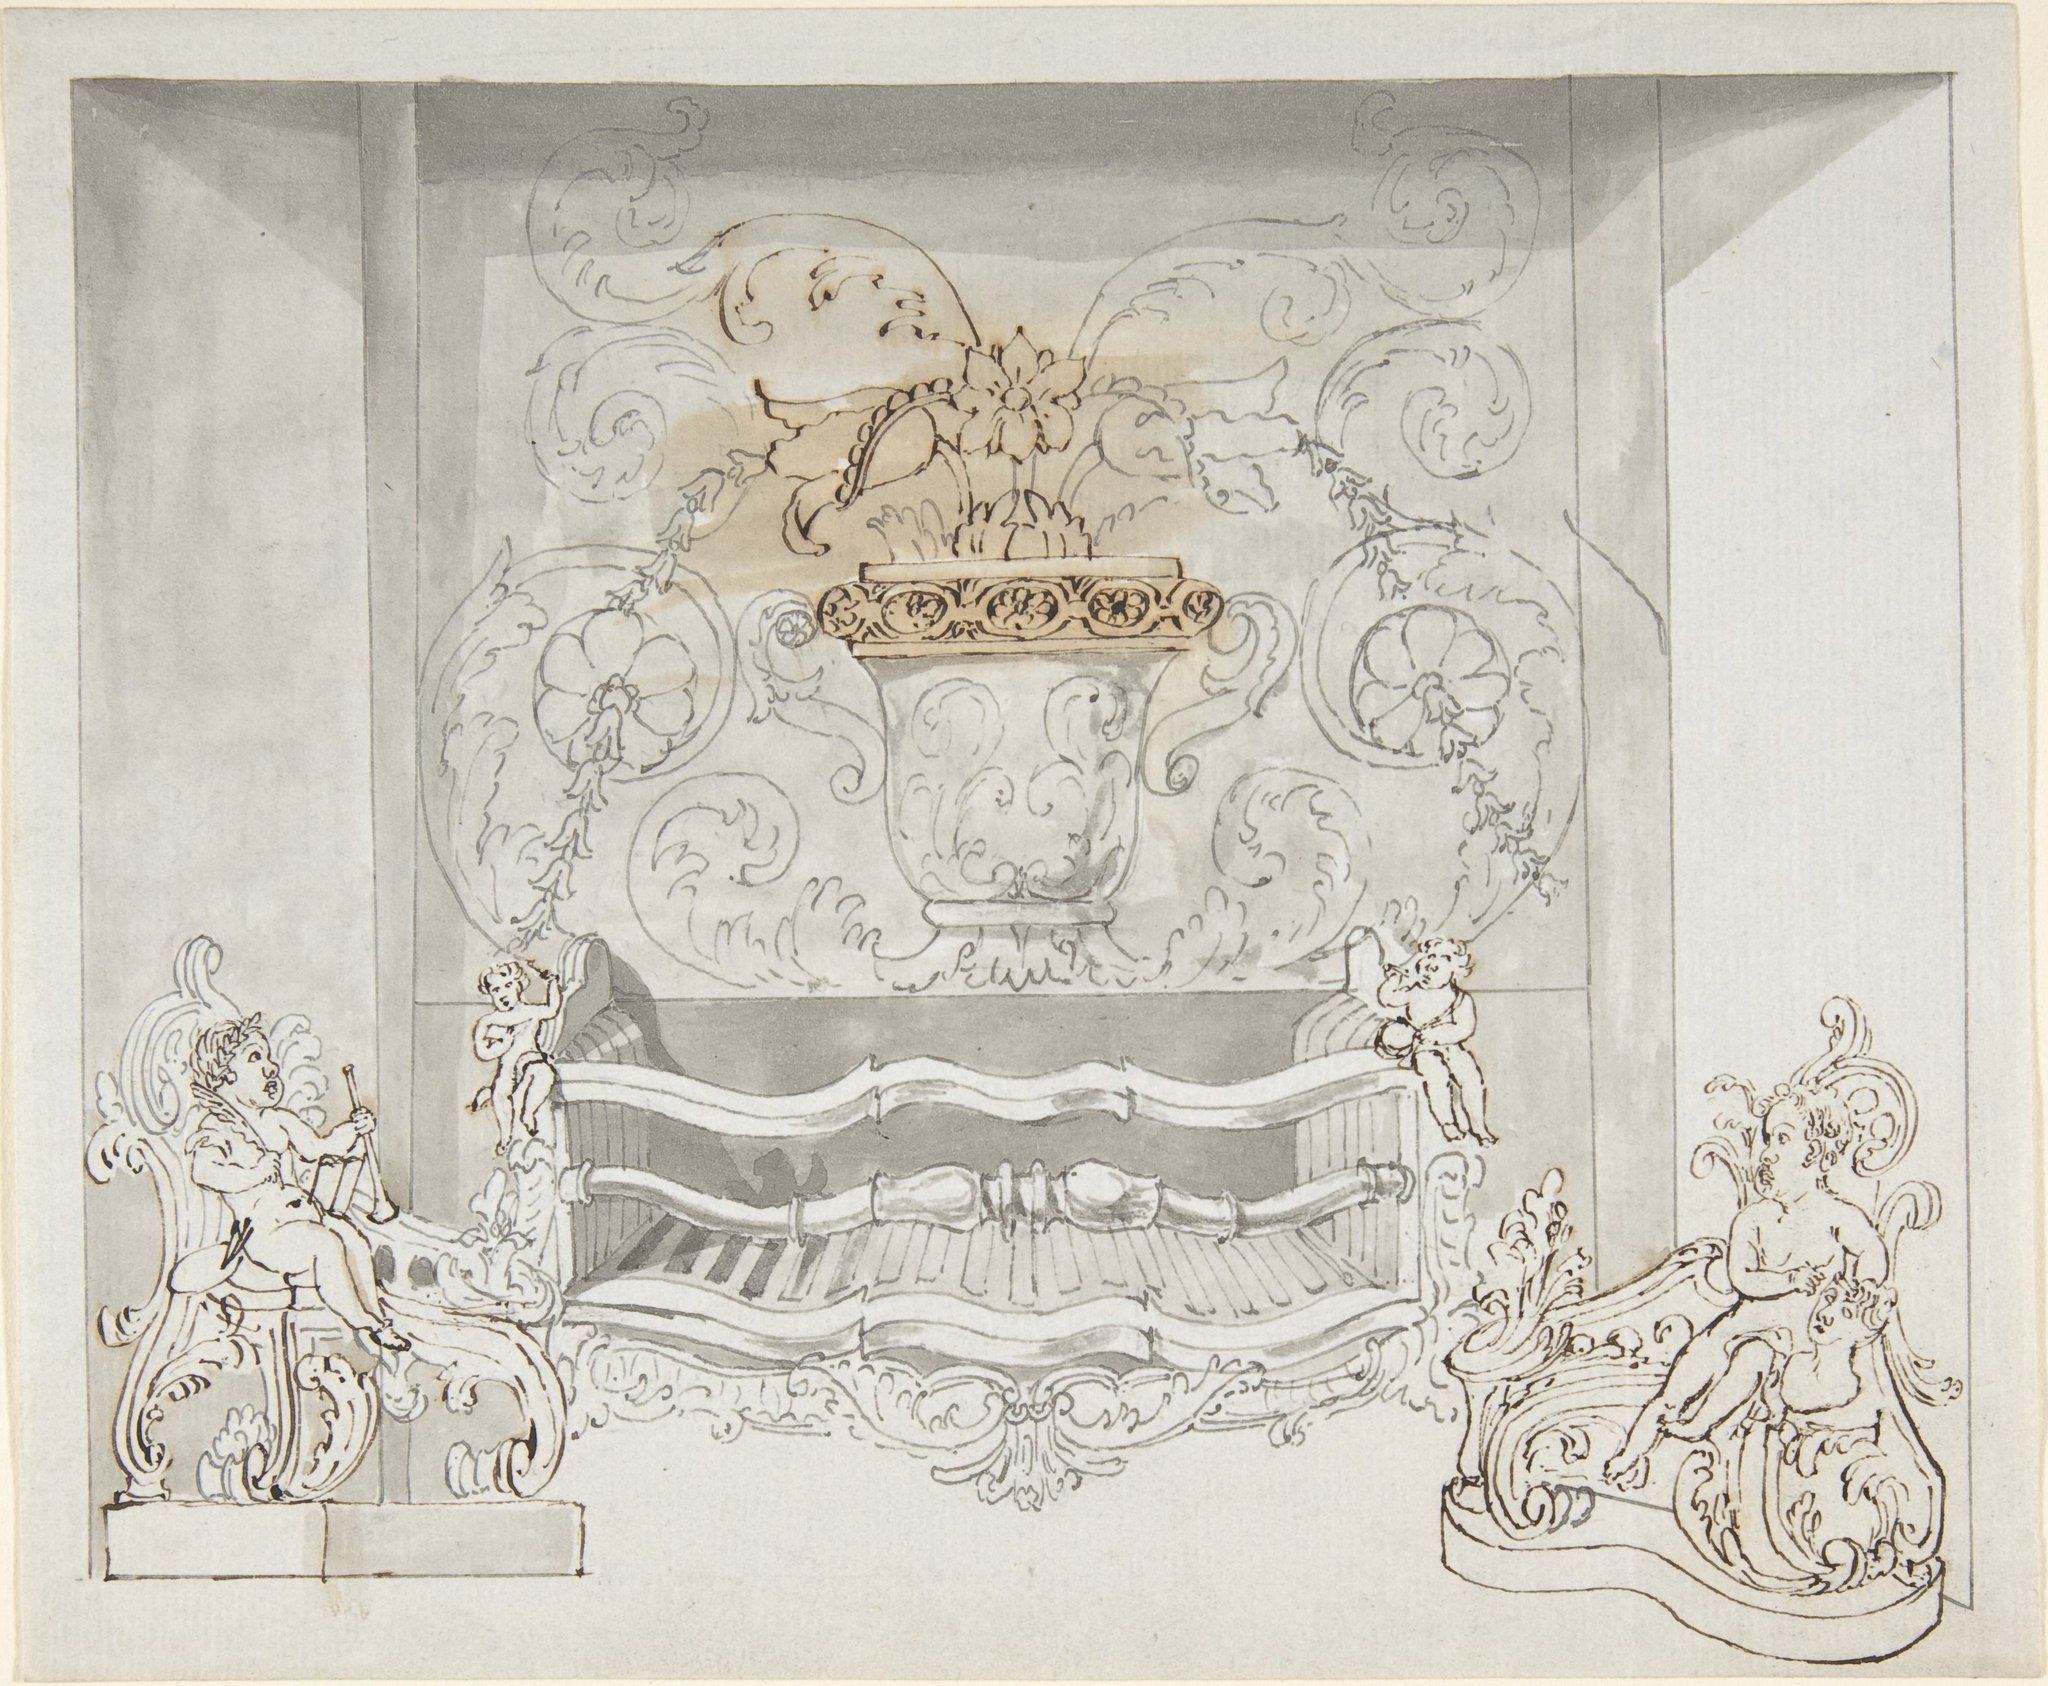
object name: drawing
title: Design for a Cast-iron Grate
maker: benjamin dean wyatt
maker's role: artist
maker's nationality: british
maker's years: 1775-1850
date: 1814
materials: ink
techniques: brush, pen, wash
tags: ornament